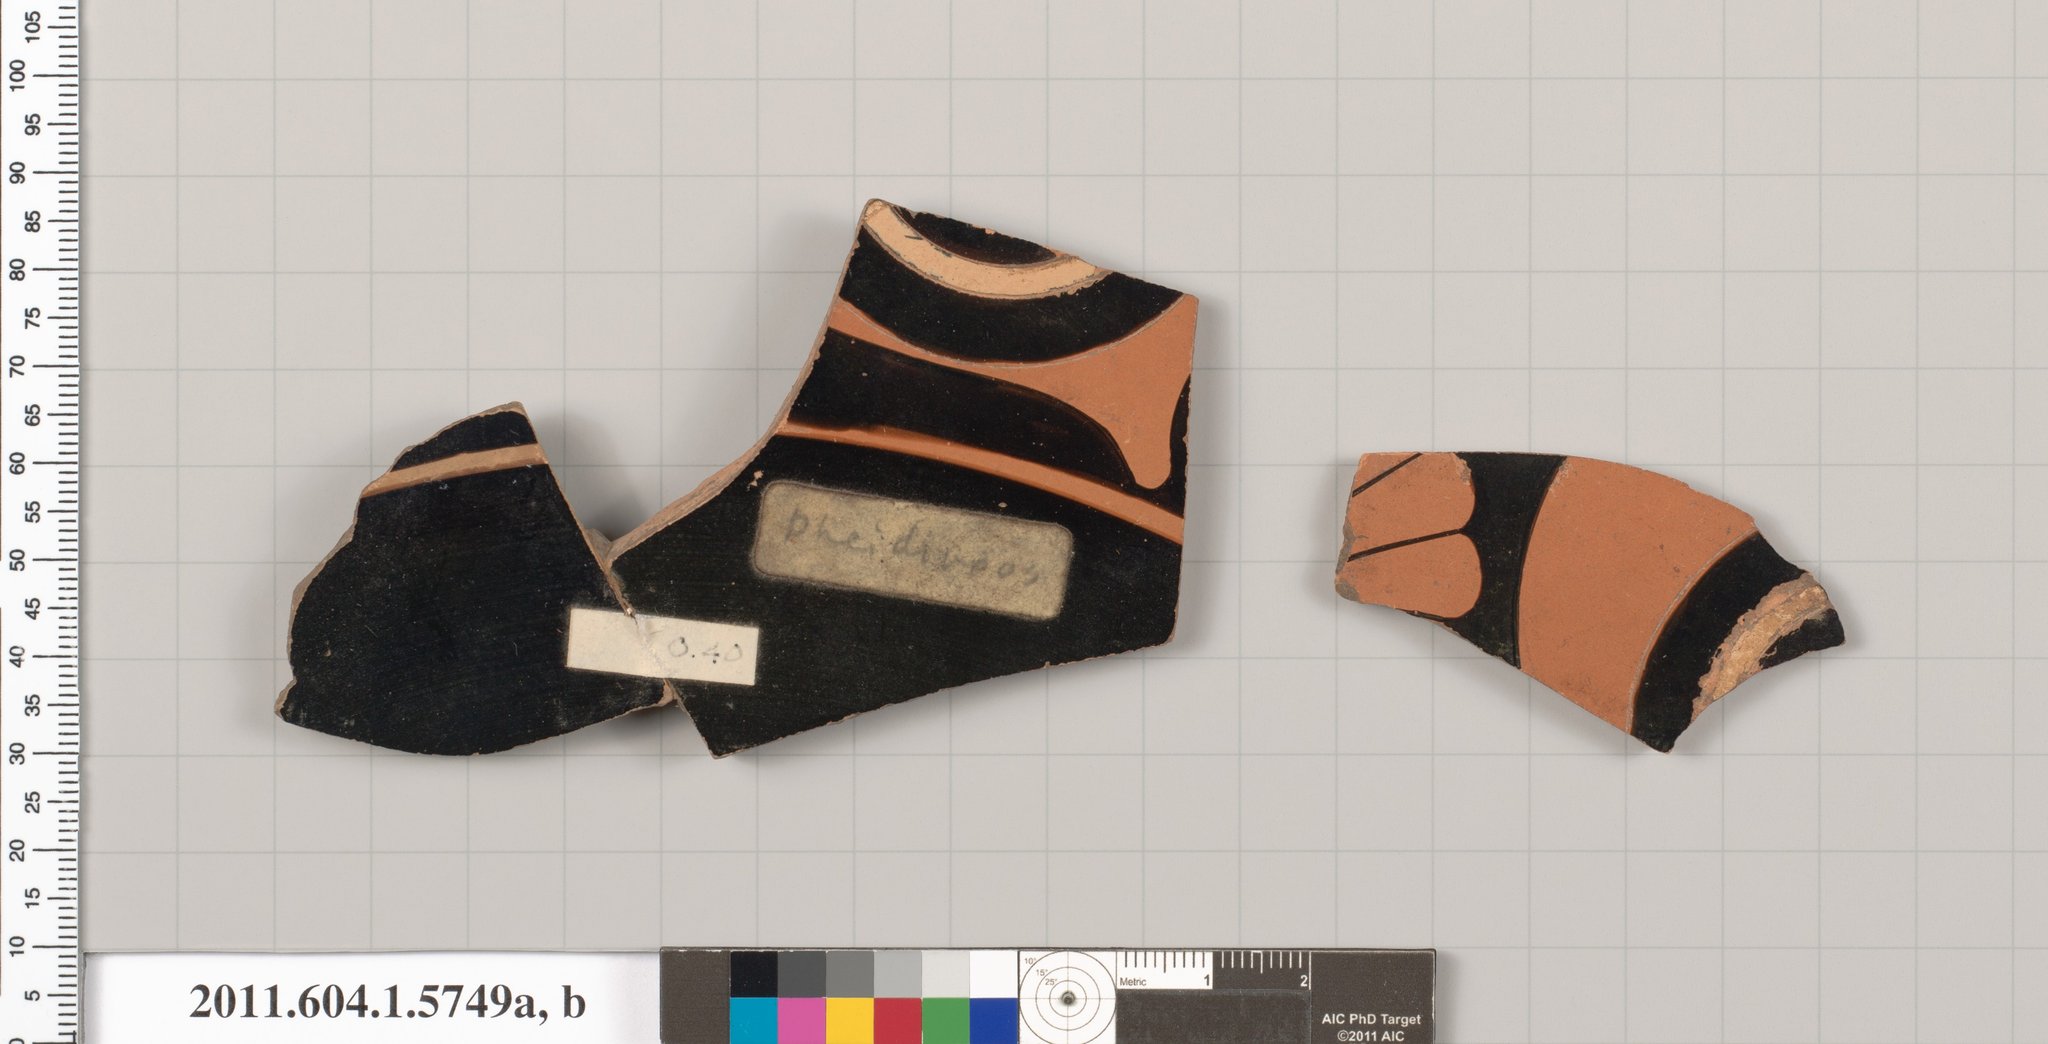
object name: kylix fragment, eye cup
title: Terracotta fragments of a kylix: eye-cup (drinking cup)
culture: greek, attic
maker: pheidippos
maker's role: artist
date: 525-510 BCE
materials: terracotta